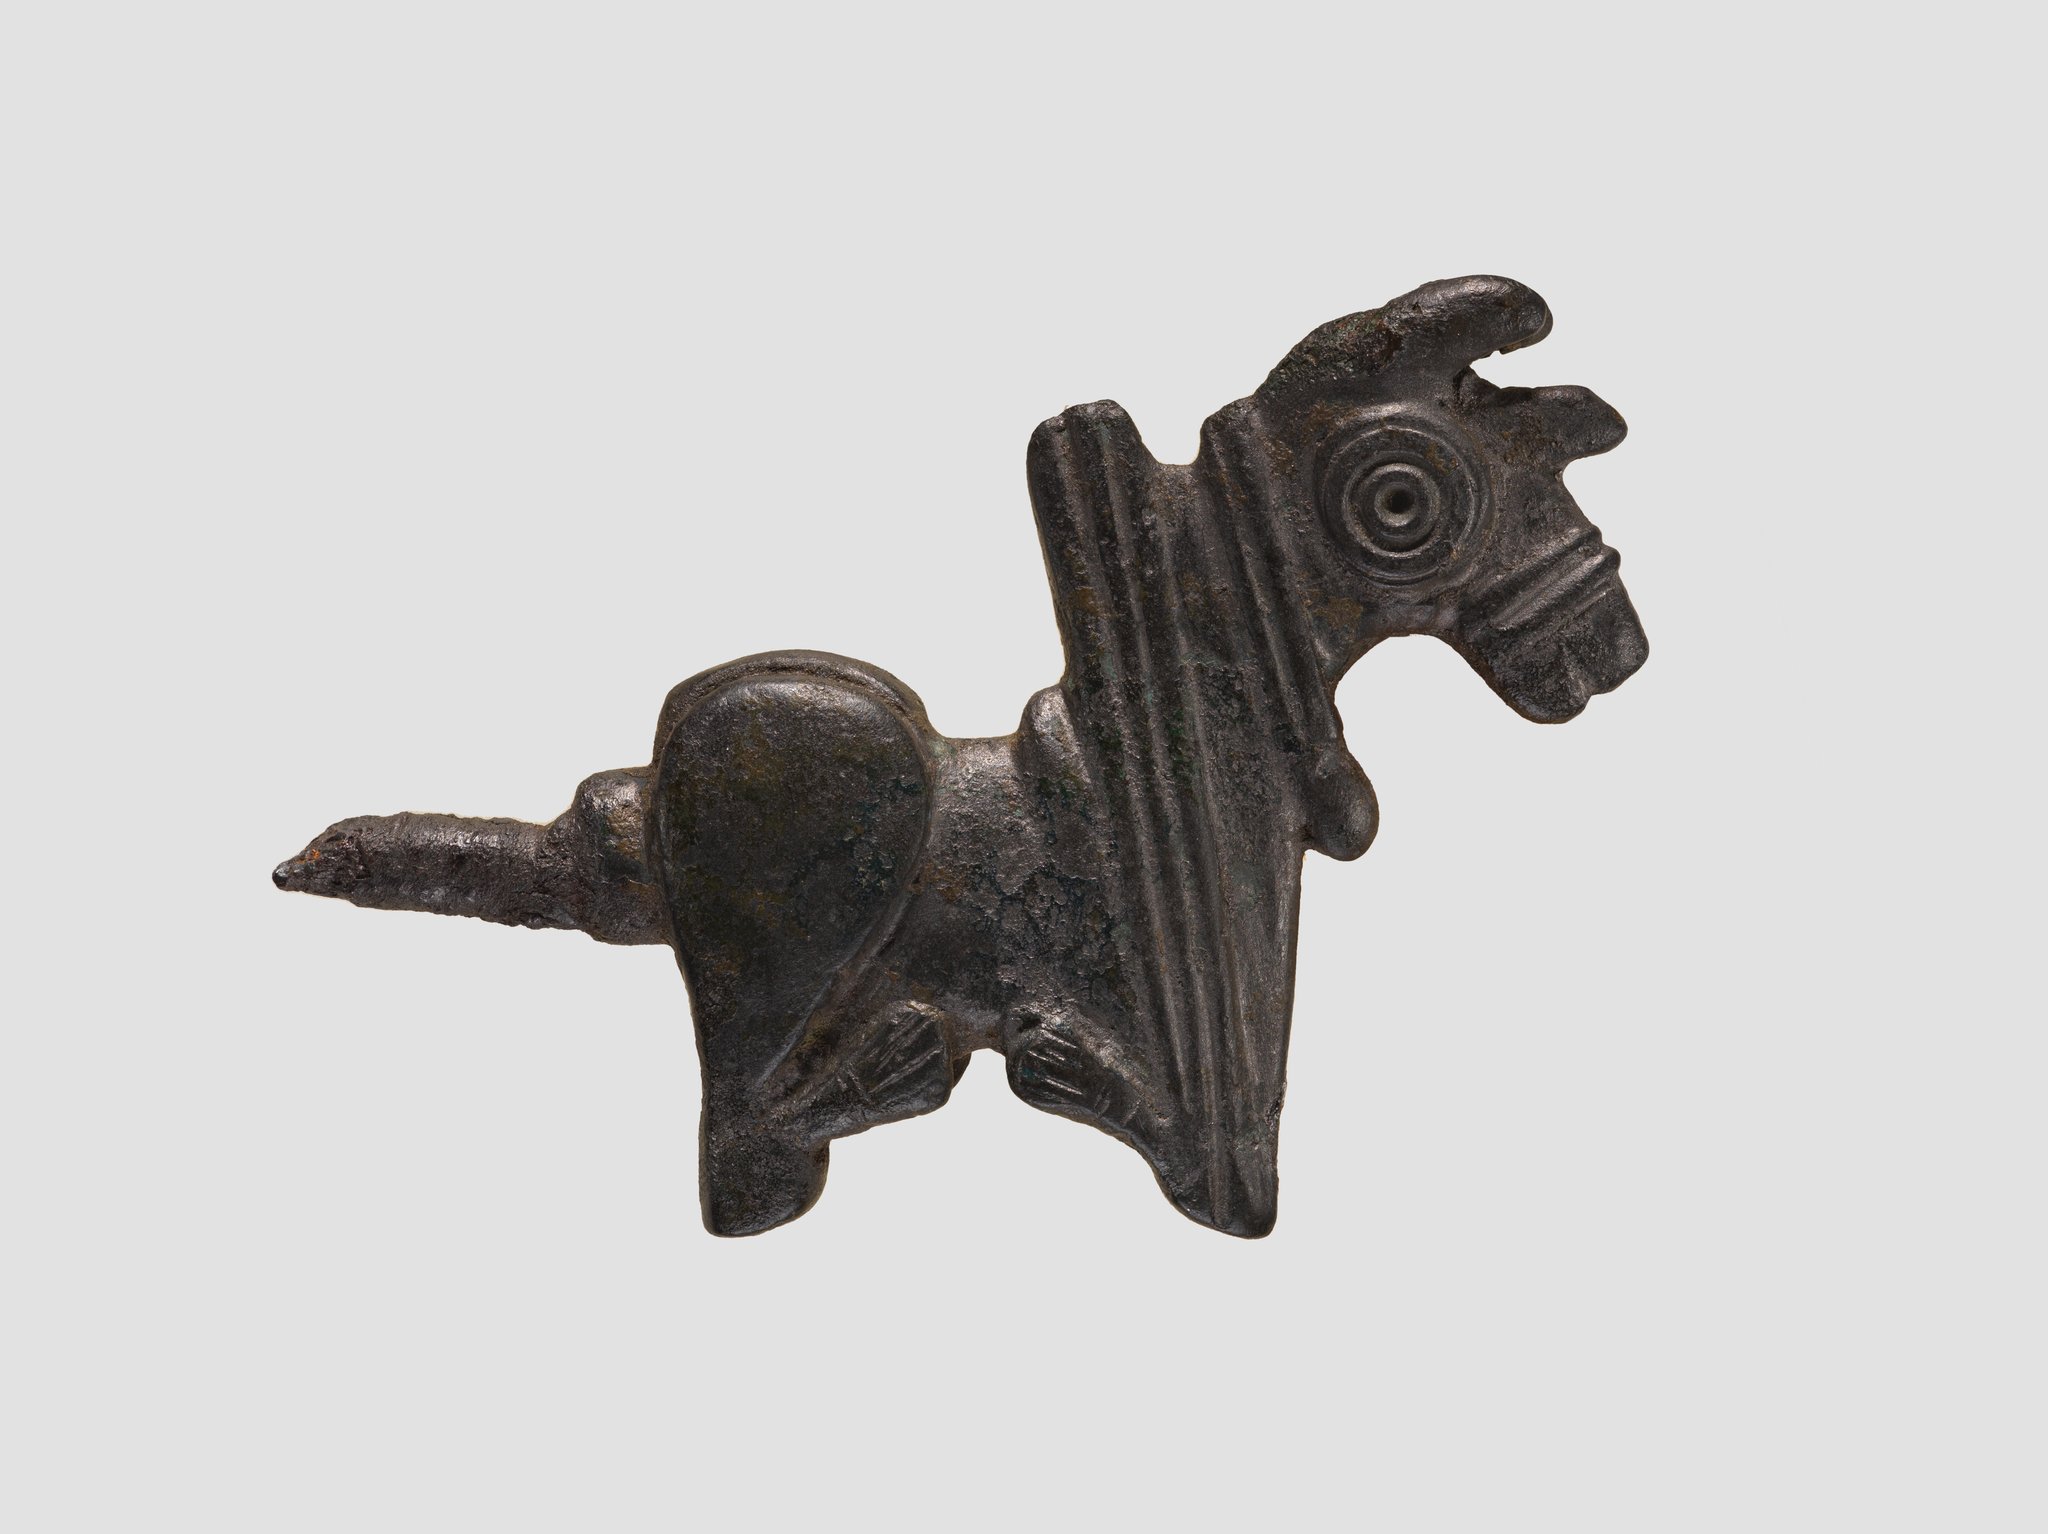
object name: pin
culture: iranian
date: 800-601 BCE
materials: bronze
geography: iran, probably from luristan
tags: horses